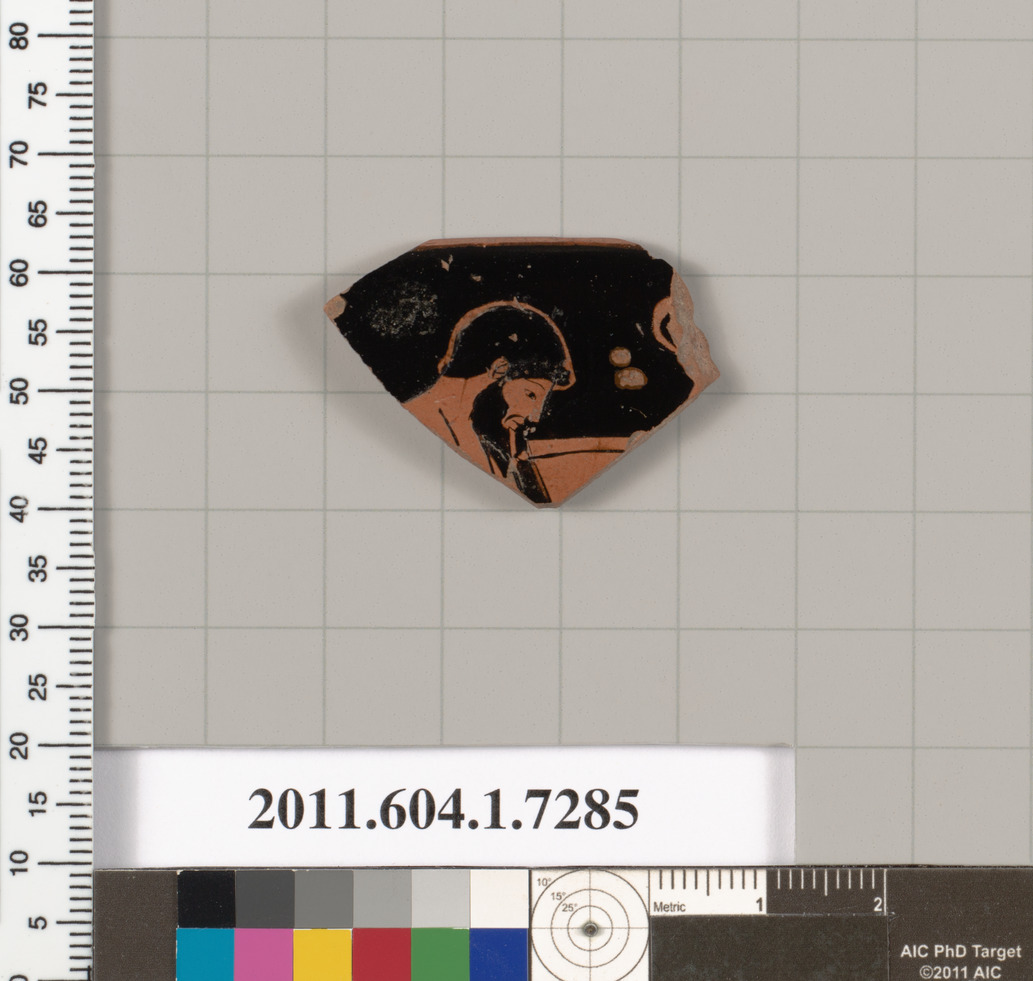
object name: kylix fragment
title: Terracotta rim fragment of a kylix (drinking cup)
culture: greek, attic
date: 500-480 BCE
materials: terracotta